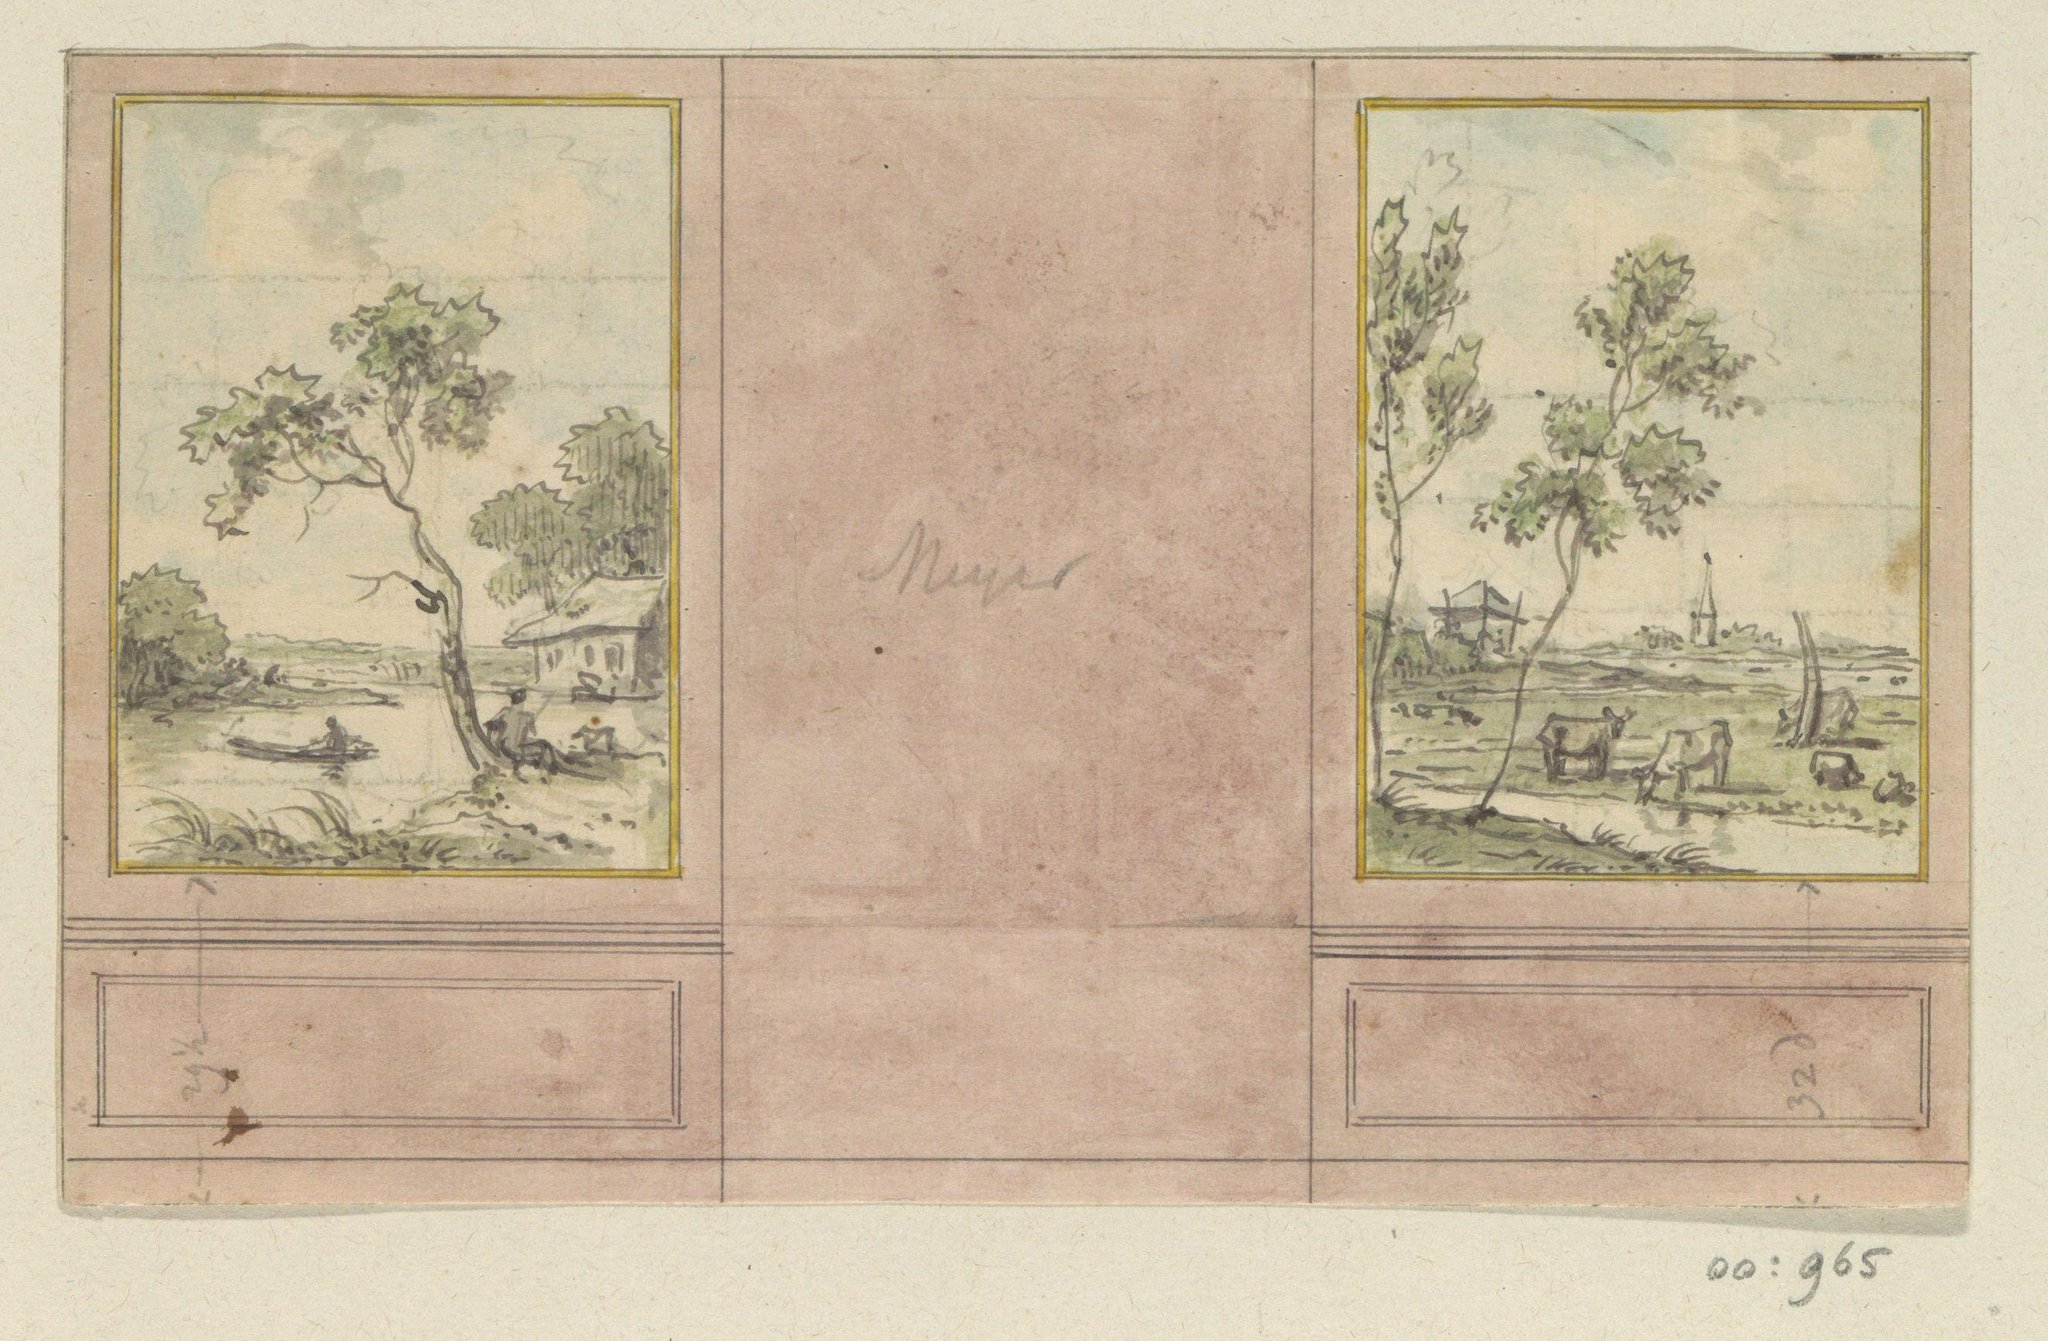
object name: album leaf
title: Ontwerptekening voor een kamerwand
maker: jurriaan andriessen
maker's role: draughtsman, painter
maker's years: 1742-1819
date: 1760-1819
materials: paint, paper, pencil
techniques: brush, pen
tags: landscapes in the temperate zone, wall-covering, pastorals, arcadian scenes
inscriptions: inscription: ‘Meyer(?)’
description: Met aan beide kanten een waterlandschap. Tekening maakt deel uit van een album.